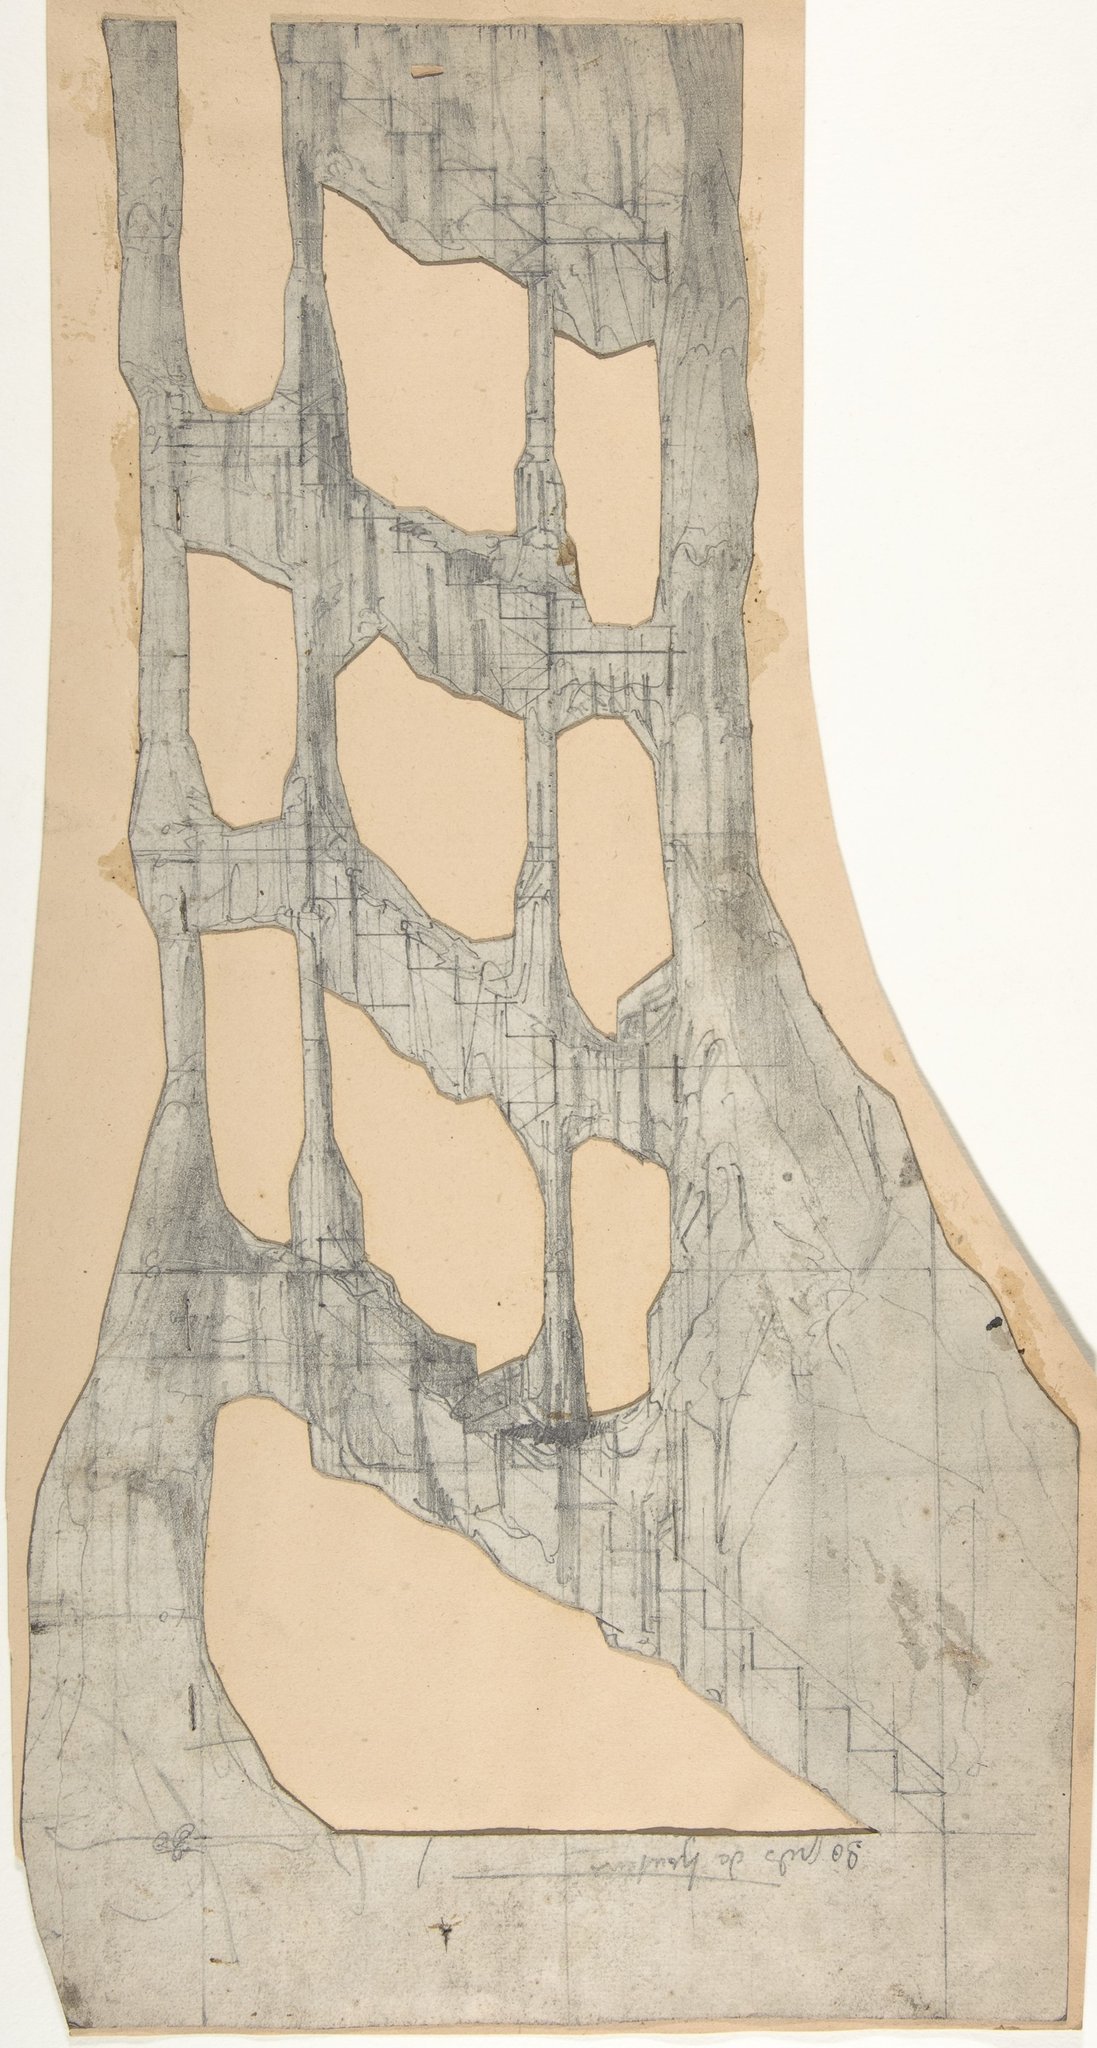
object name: drawing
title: Design for a Stage Set at the Opéra, Paris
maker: eugène cicéri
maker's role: artist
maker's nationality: french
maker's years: 1813-1890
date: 1828-1890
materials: graphite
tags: stage design